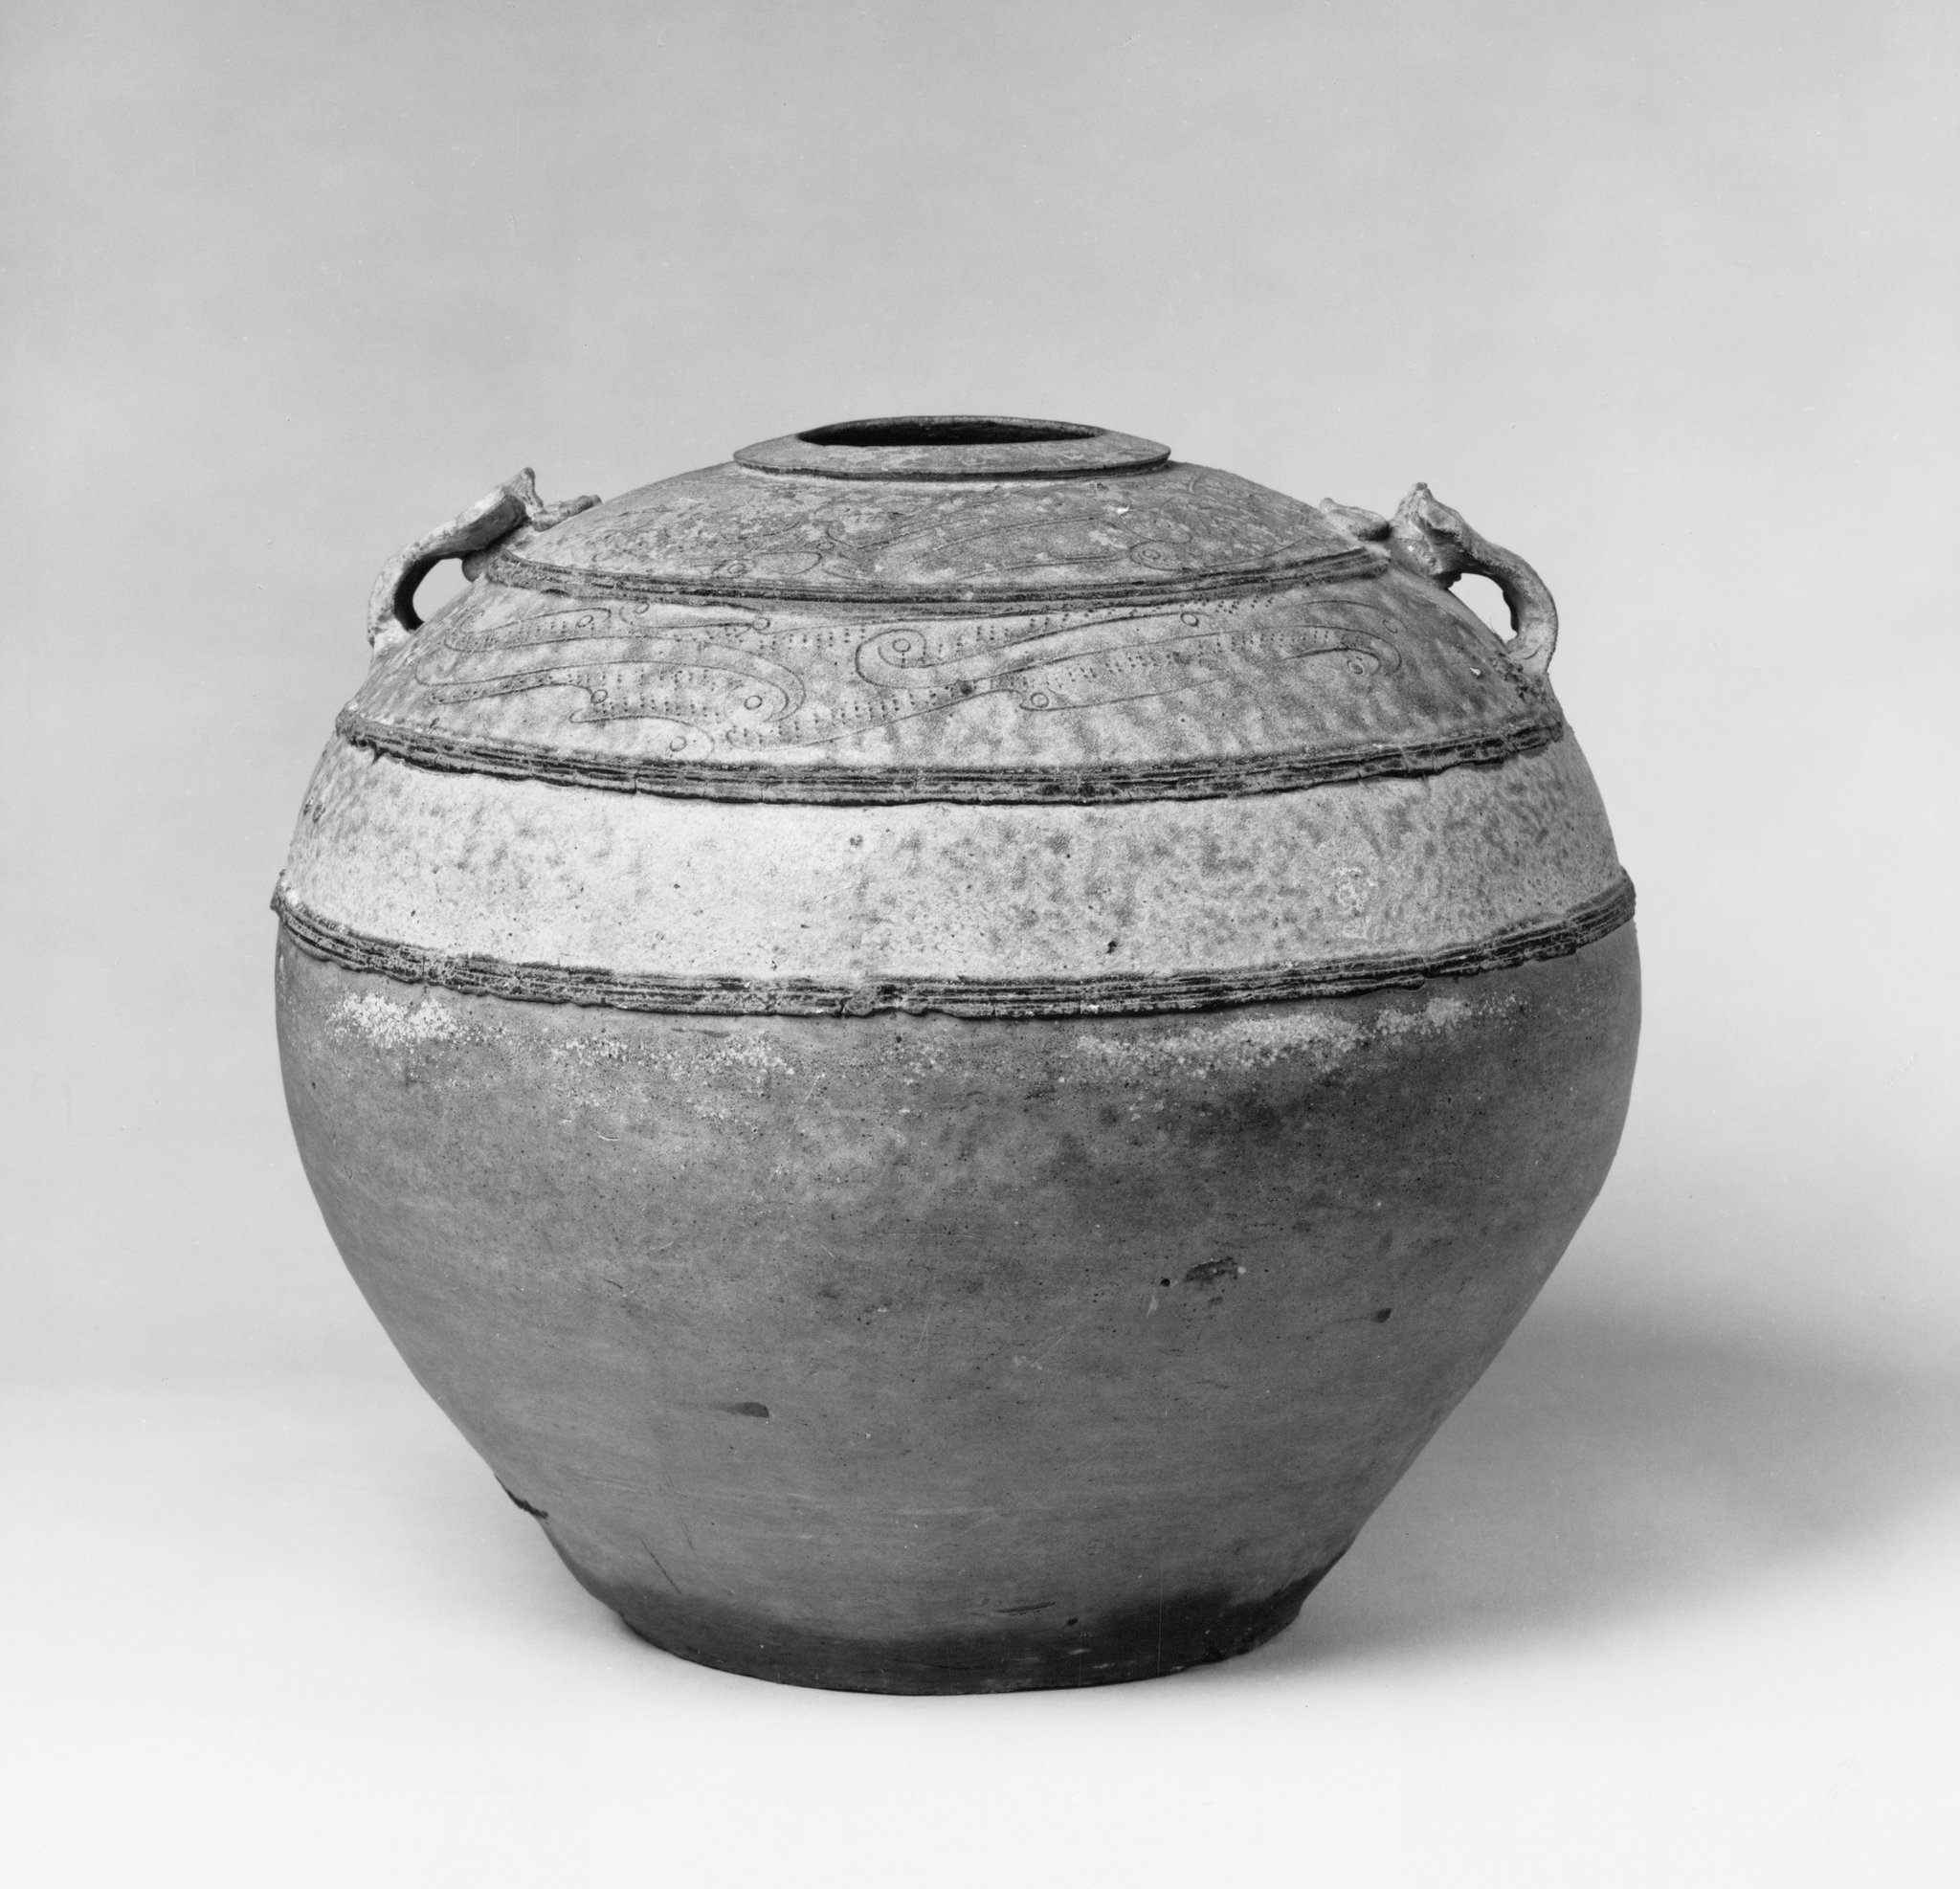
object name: jar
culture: chinese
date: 100-1 BCE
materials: earthenware, glaze